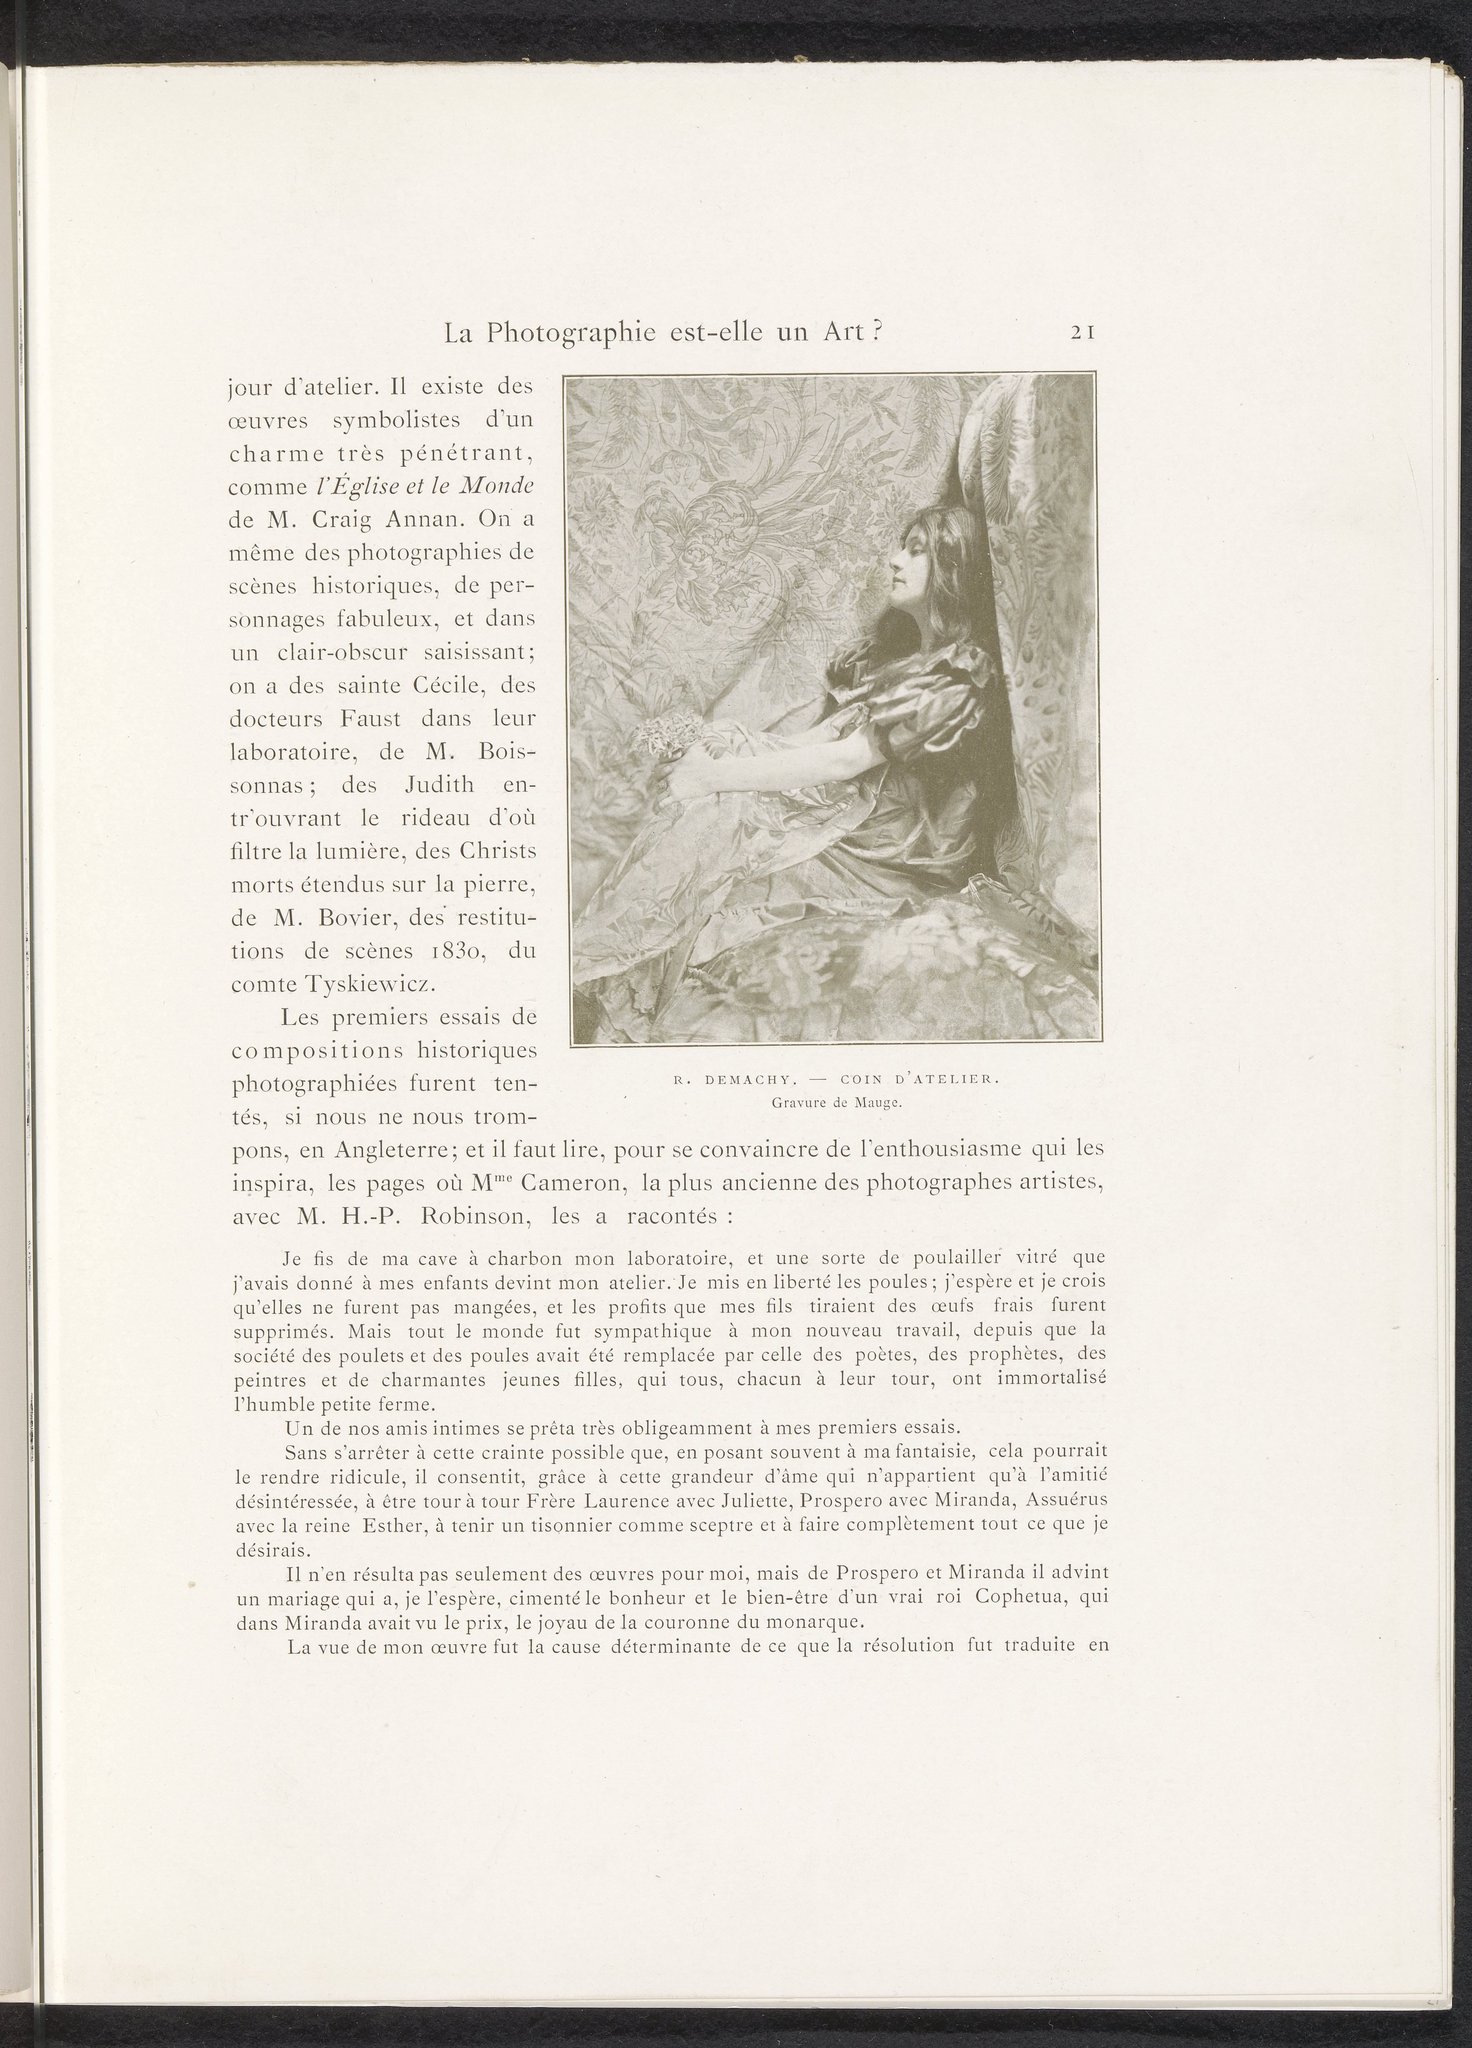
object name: photomechanical print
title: Coin d'atelier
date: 1889-1899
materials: paper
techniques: autotype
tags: ornament derived from plant forms